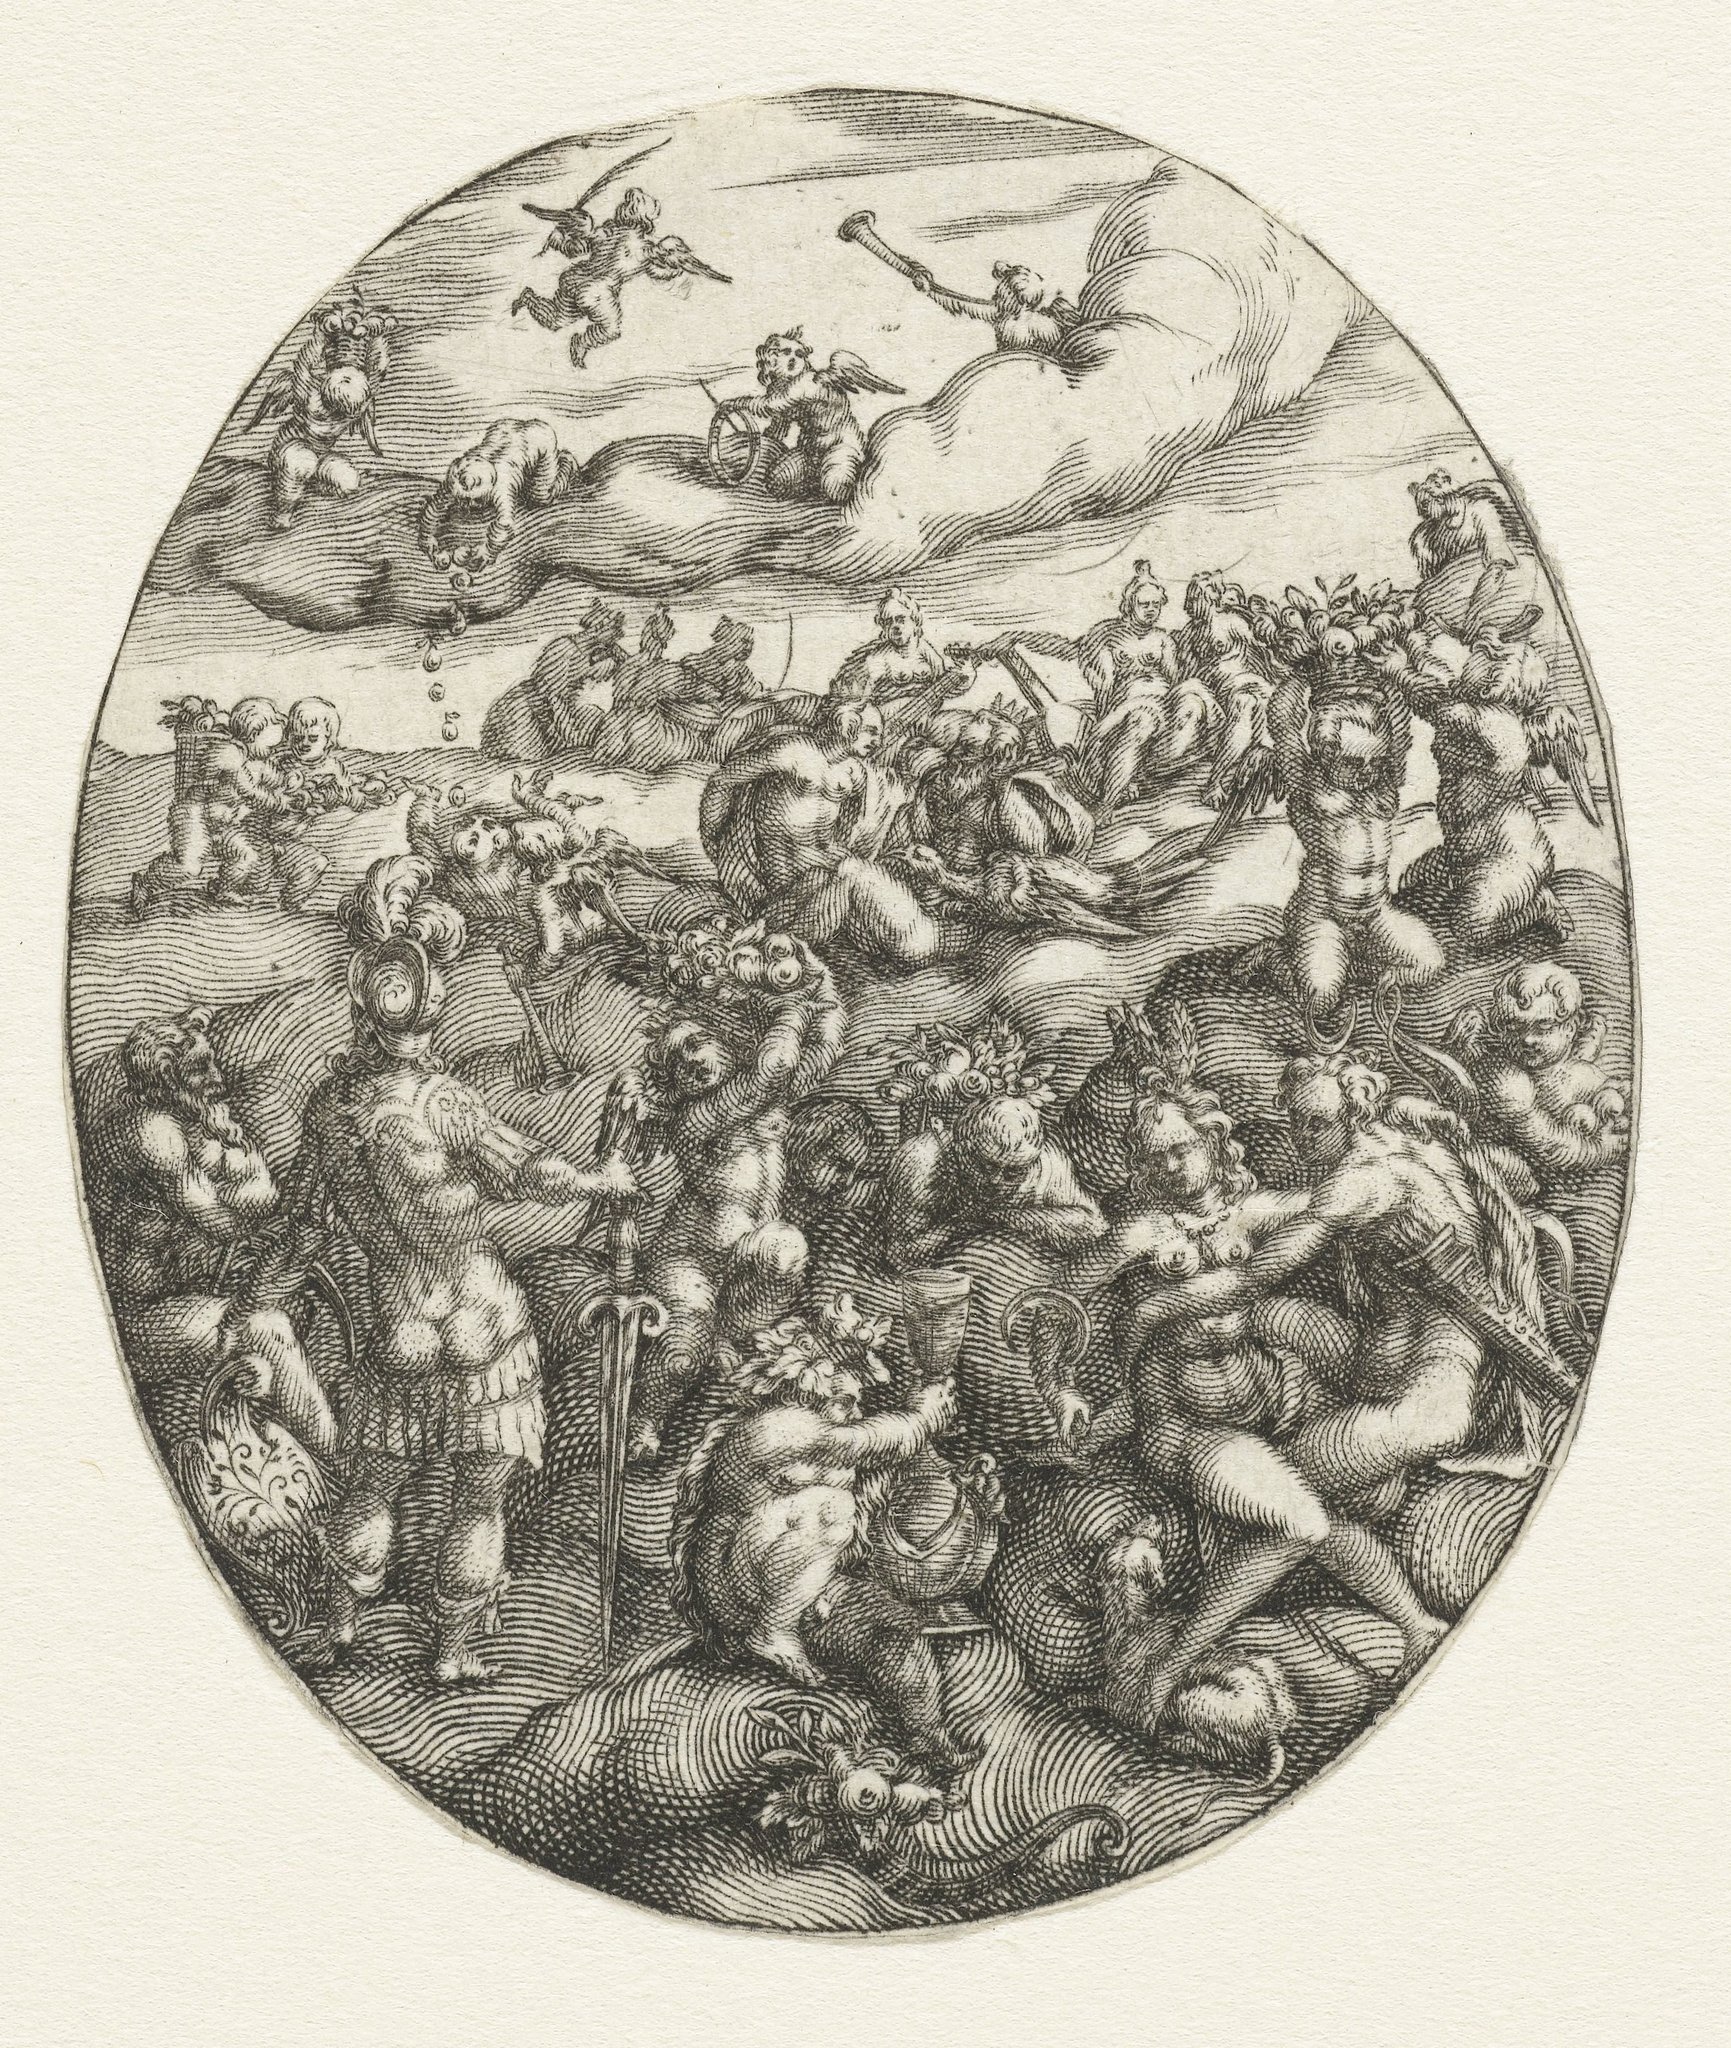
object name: print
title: Konstbüchlein den Goldschmiden dienstlich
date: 1608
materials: paper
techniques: engraving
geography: amsterdam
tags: the olympian gods together: jupiter, juno, neptune, ceres, apollo, diana, mars, venus, mercury, minerva, vulcan, vesta (or bacchus), more than one musician with instrument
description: Van links naar rechts: Mars, Juno en Jupiter, Bacchus en Diana. Bovenaan musicerende putti. Blad uit serie bestaande uit een titelblad en 11 bladen met ontwerpen voor horlogedeksels.